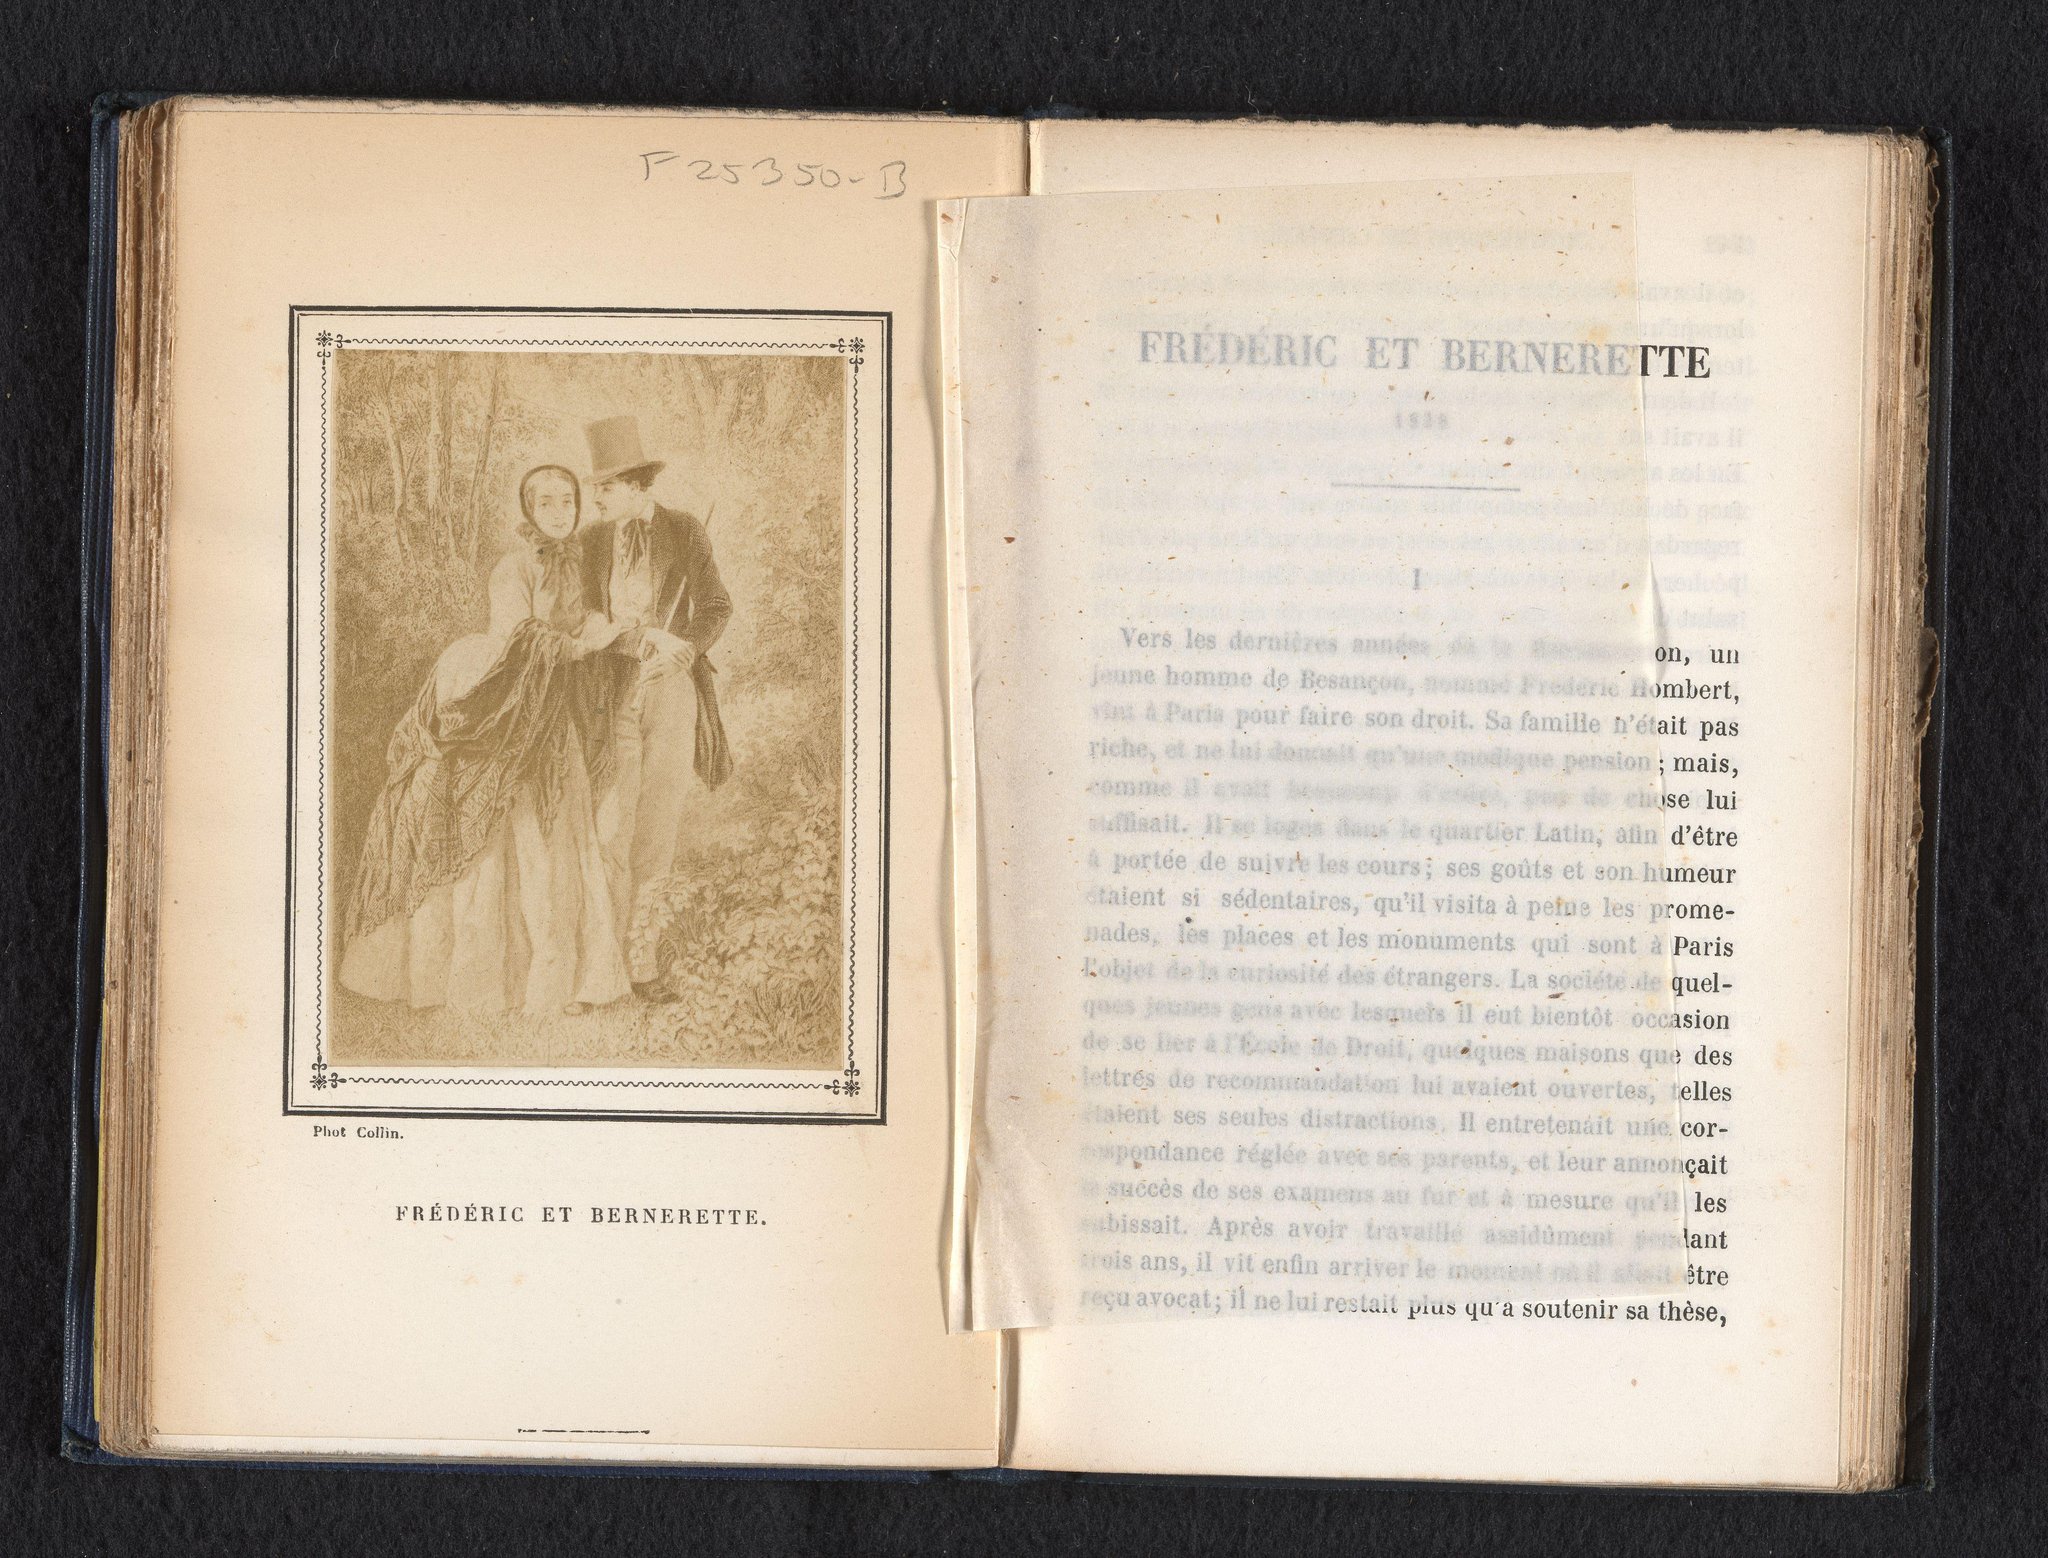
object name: reproduction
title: Frederic et Bernerette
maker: collin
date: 1862-1867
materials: paper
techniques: albumen print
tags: print, e.g.: engraving, etching, lithograph